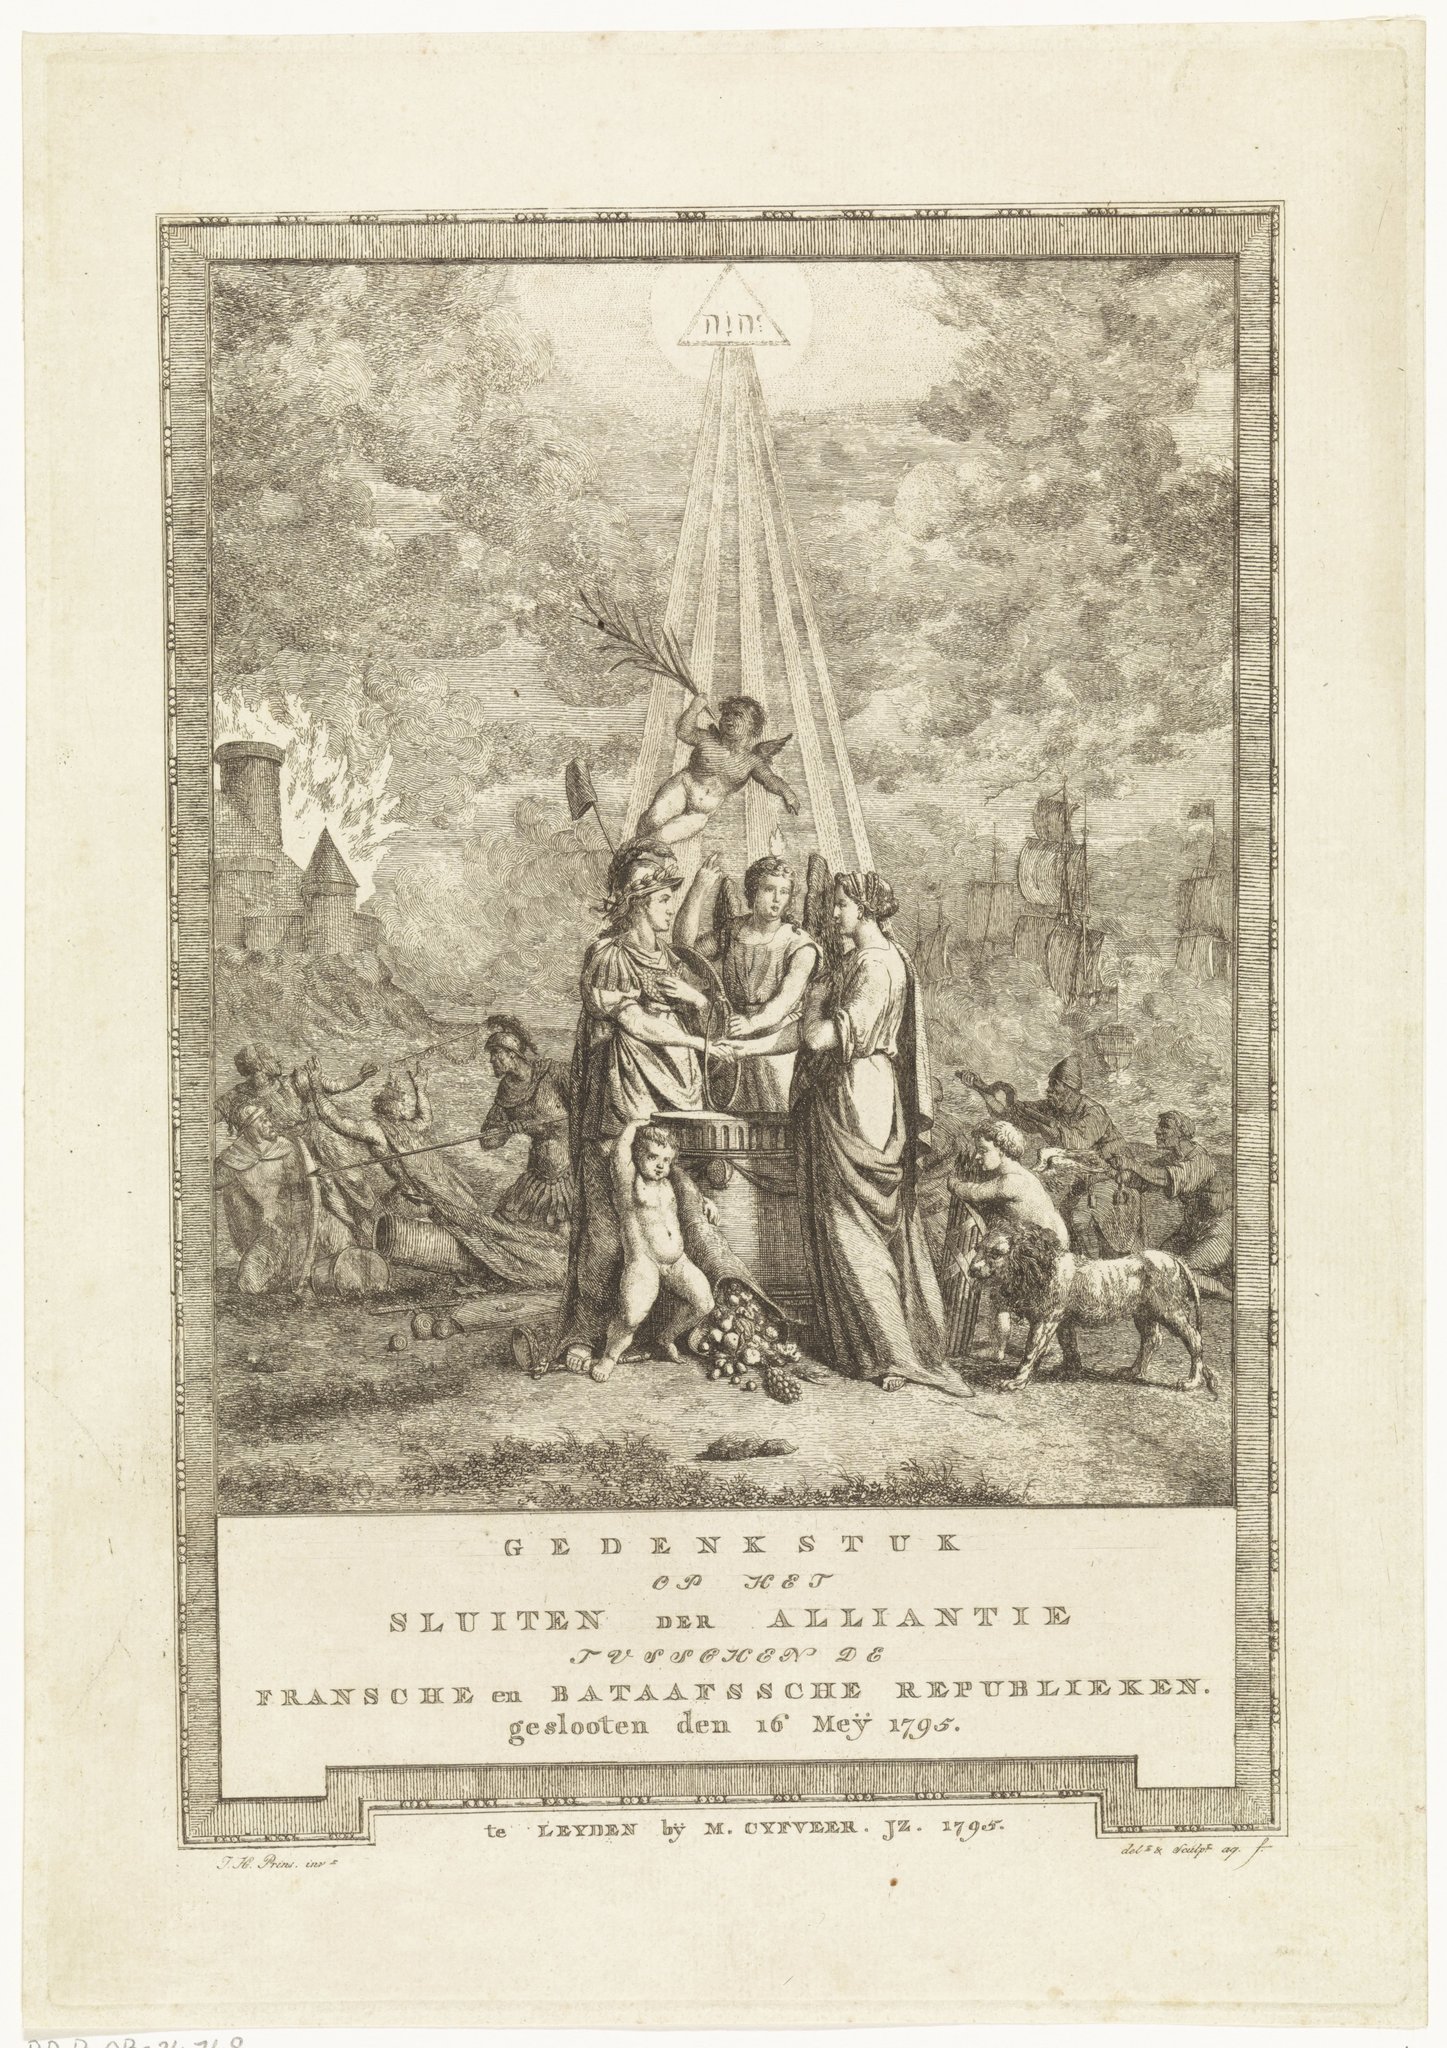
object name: print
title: Gedenkstuk op het Sluiten der Alliantie tusschen de Fransche en Bataafsche Republieken. geslooten den 16 Mey 1795."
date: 1795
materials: paper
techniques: etching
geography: leiden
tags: tetragram (in roman or hebrew script) ~ symbol of god the father, freedom, liberty; 'libertà' (ripa), merchant shipping, shipping trade, alliance, league, union, foedus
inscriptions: collector's mark: Lugt 2228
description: Allegorische voorstelling op het bondgenootschap tussen Nederland en Frankrijk, 1795. In het midden reiken de Maagden der Franse en Bataafse republiek elkaar boven een altaar de hand door een slangenring, die wordt vastgehouden door een gevleugelde Vrijheid. Het geheel wordt beschenen door het licht afkomstig van een zon met Tetragrammaton. Boven de Vrijheid vliegt een putto met een palmtak. Links wordt voor een brandend kasteel de dwingelandij verjaagd, rechts zijn schepen te zien die de herlevende zeehandel symboliseren.